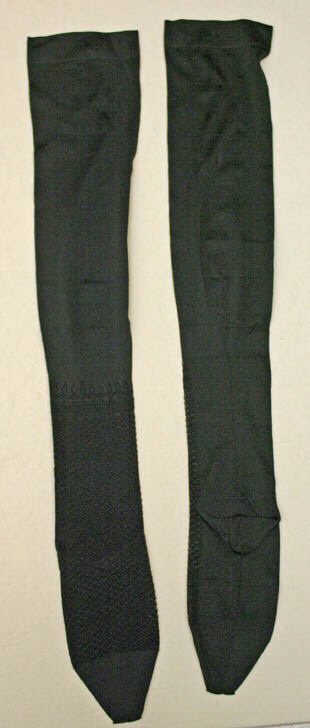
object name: stocking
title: Stockings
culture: british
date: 1894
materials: silk